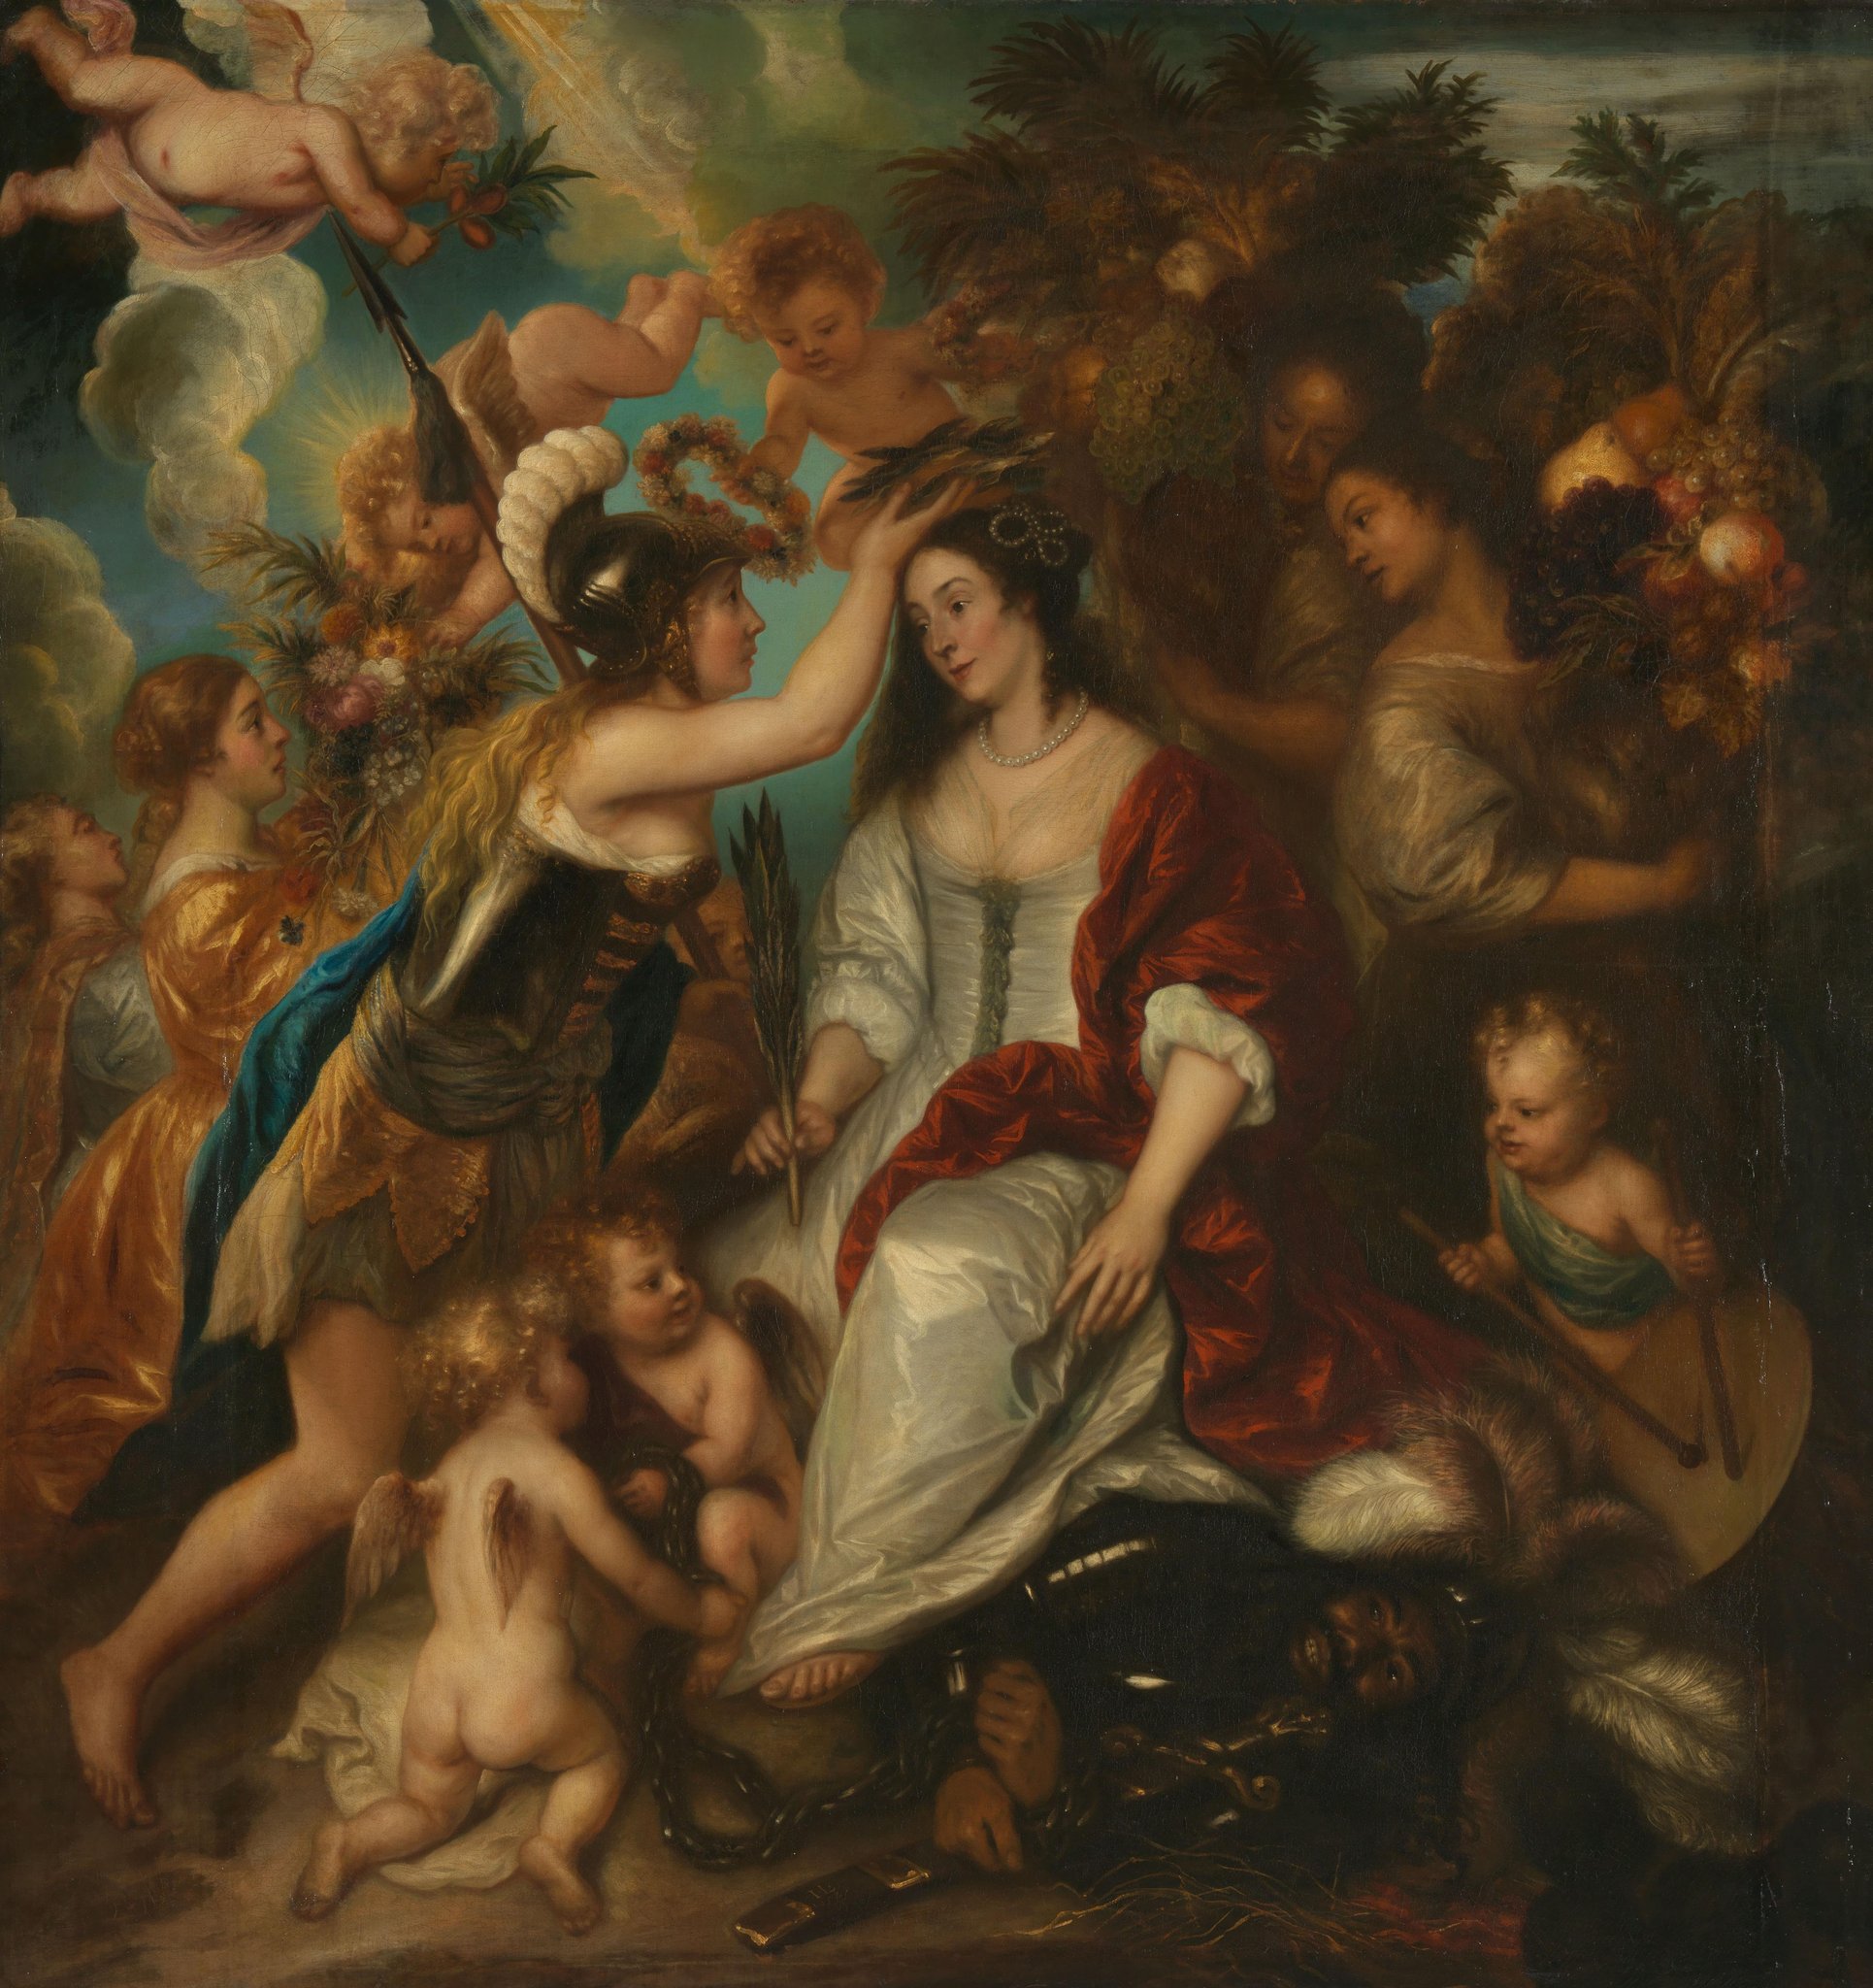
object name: painting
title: Allegory of Peace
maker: jan lievens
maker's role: draughtsman, painter, print maker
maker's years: 1607-1674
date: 1652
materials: canvas, oil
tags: symbols, allegories of peace, 'pax'; 'pace' (ripa), symbols, allegories of war; 'guerra' (ripa)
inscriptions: monogram and date, bottom centre, on the scabbard: ‘I.L. / 1652.’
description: Allegorie op de vrede. De zittende vrouwelijk personificatie van Vrede wordt met een lauwerkrans gekroond door een vrouw in wapenrusting. Onder haar voeten vertrapt Vrede de personificatie van Oorlog. Rechts dragen vrouwen manden of hoornen met fruit en slaat een putto op de trom. Links ketenen twee putti de voeten van de Oorlog vast. Links enkele vrouwen en putti met bloemen.